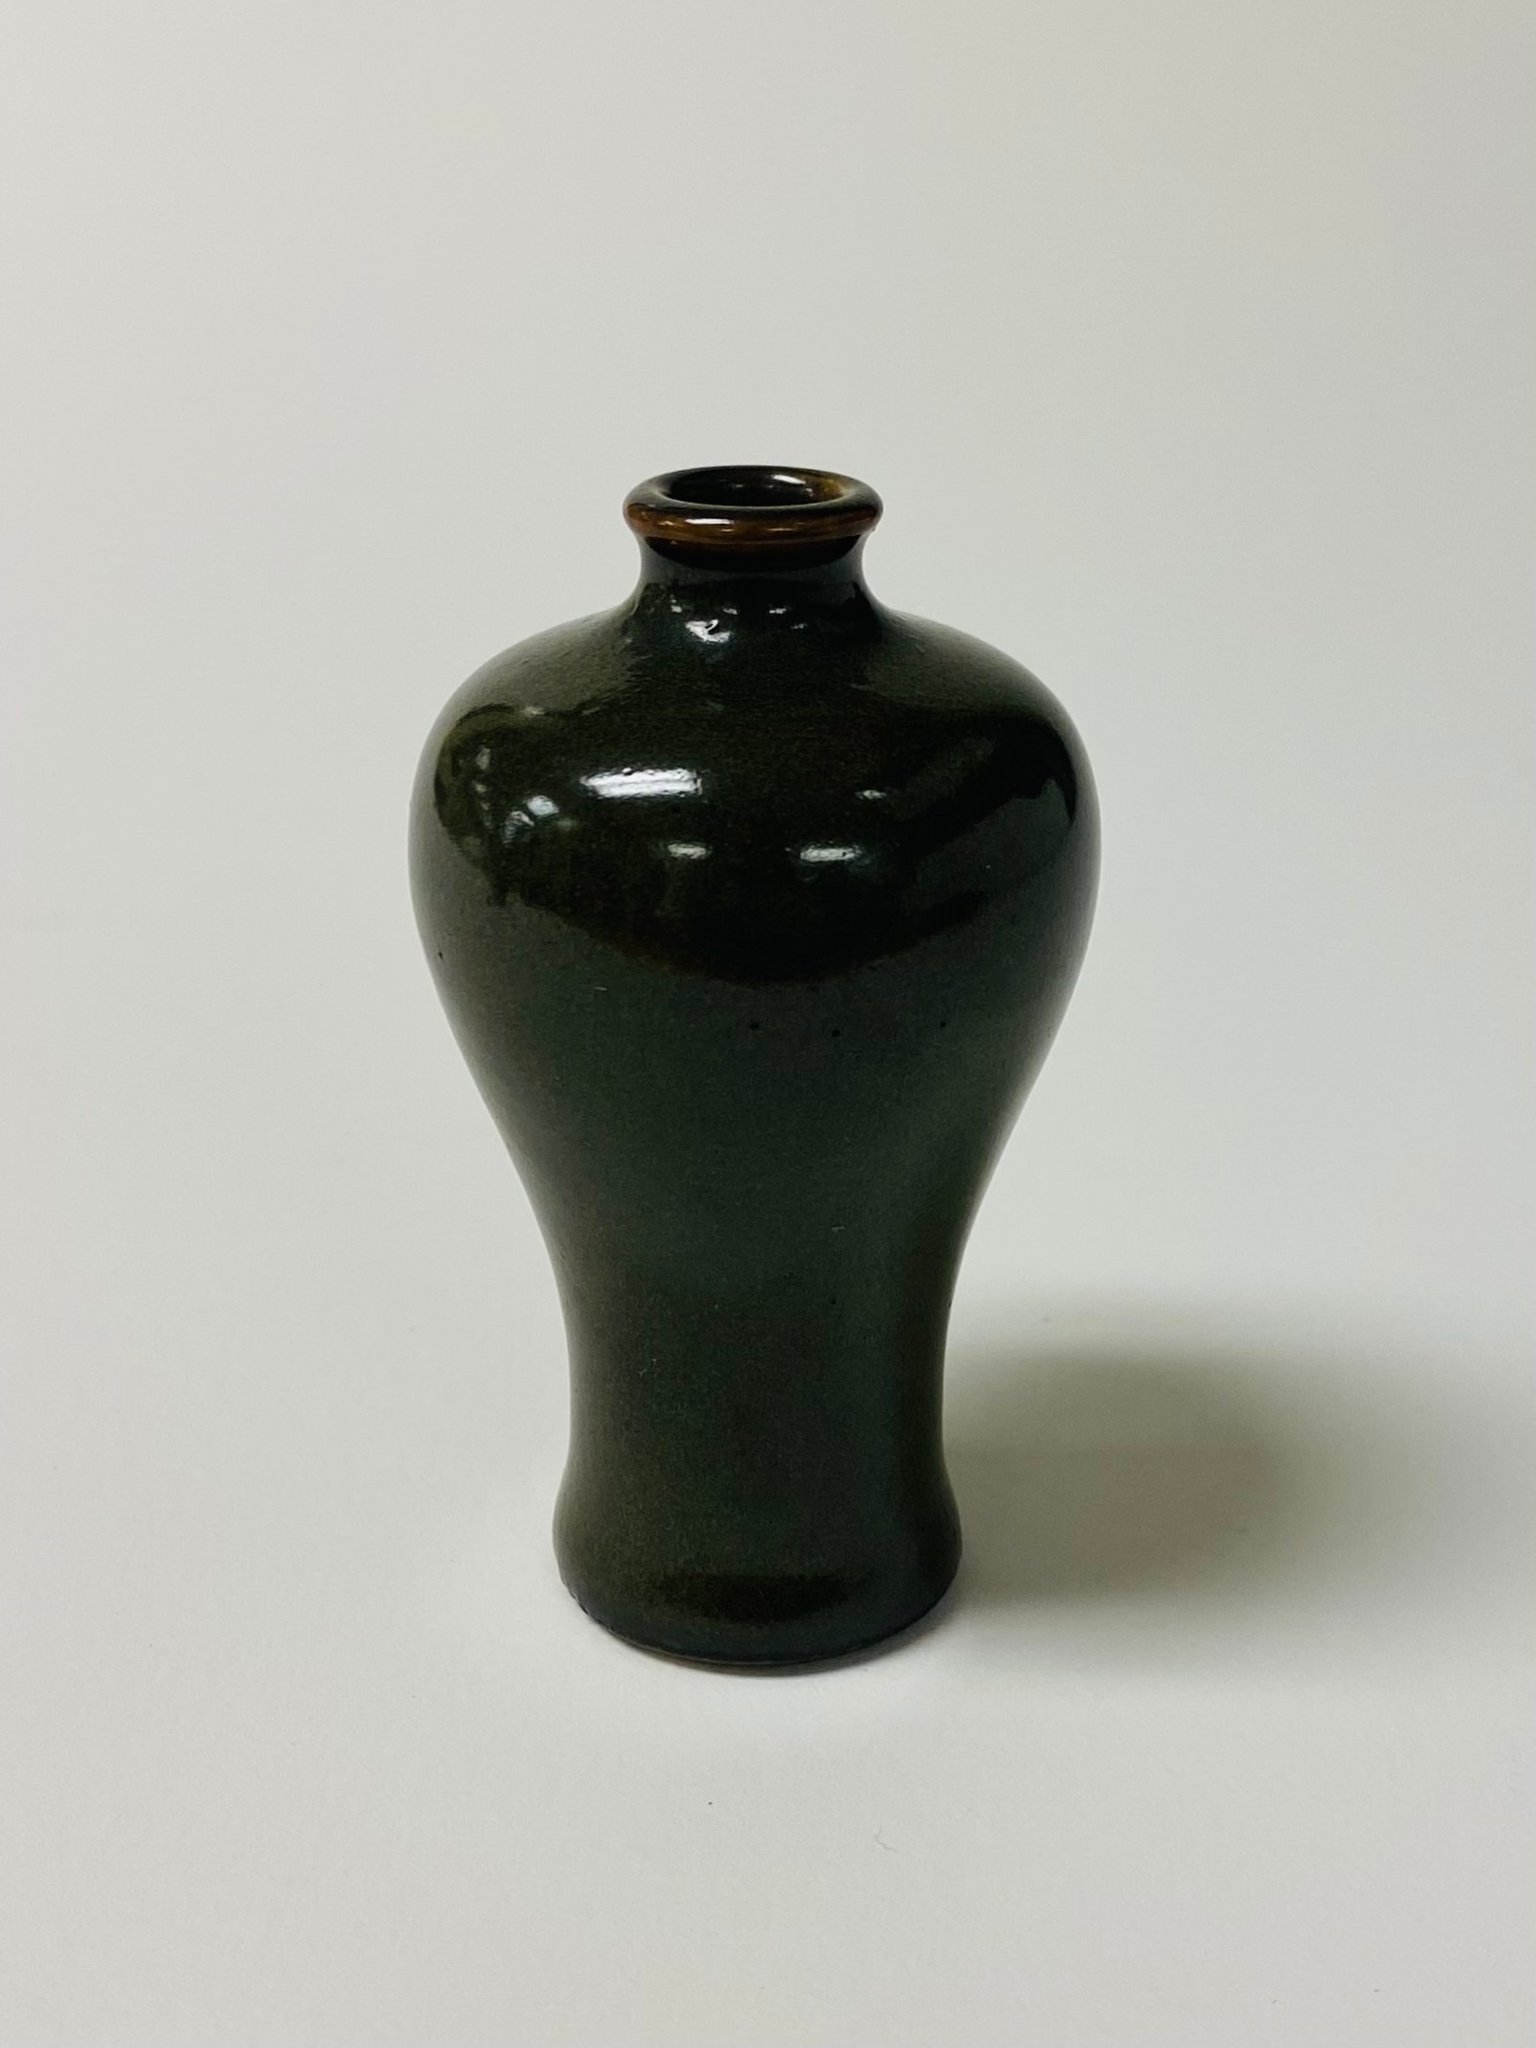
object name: vase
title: Miniature meiping vase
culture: chinese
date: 1701-1800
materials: glaze, porcelain